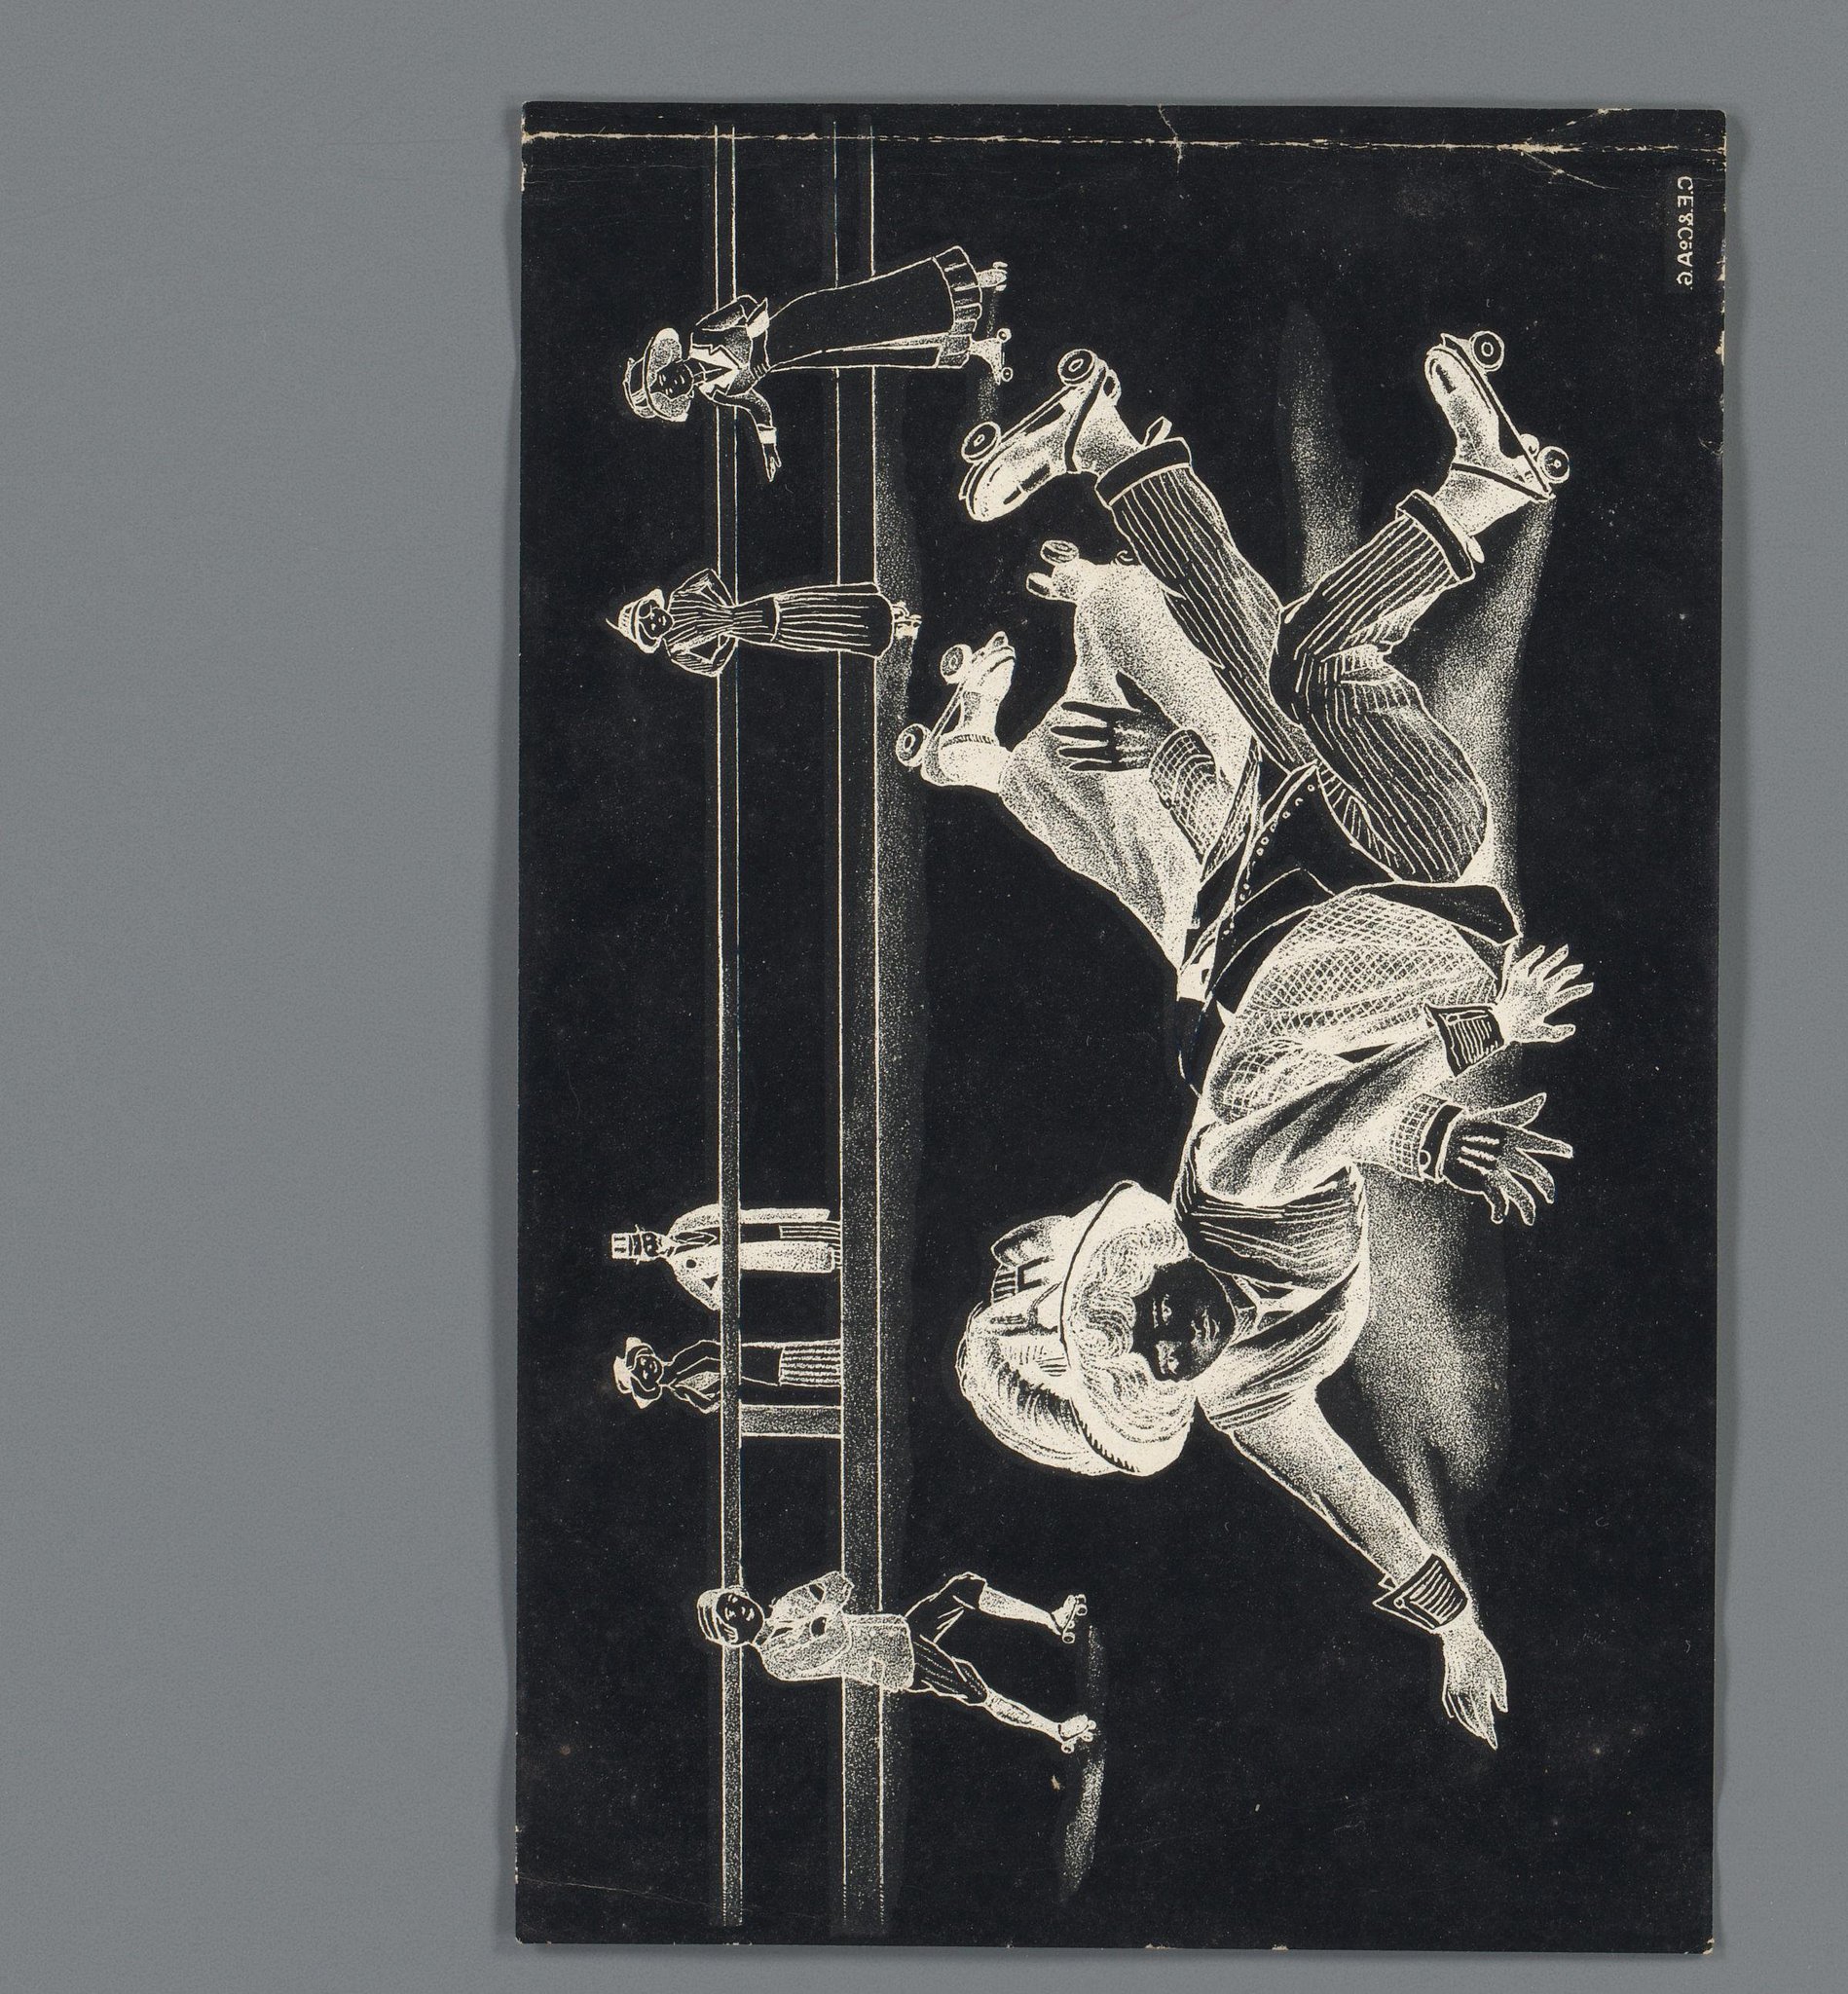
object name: print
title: Vallend rolschaatsend paar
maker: carlernco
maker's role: publisher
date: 1900-1930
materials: paper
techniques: lithograph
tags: roller-skating, roller-skates, falling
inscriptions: inscription: ‘C.E. & Co. AG.’